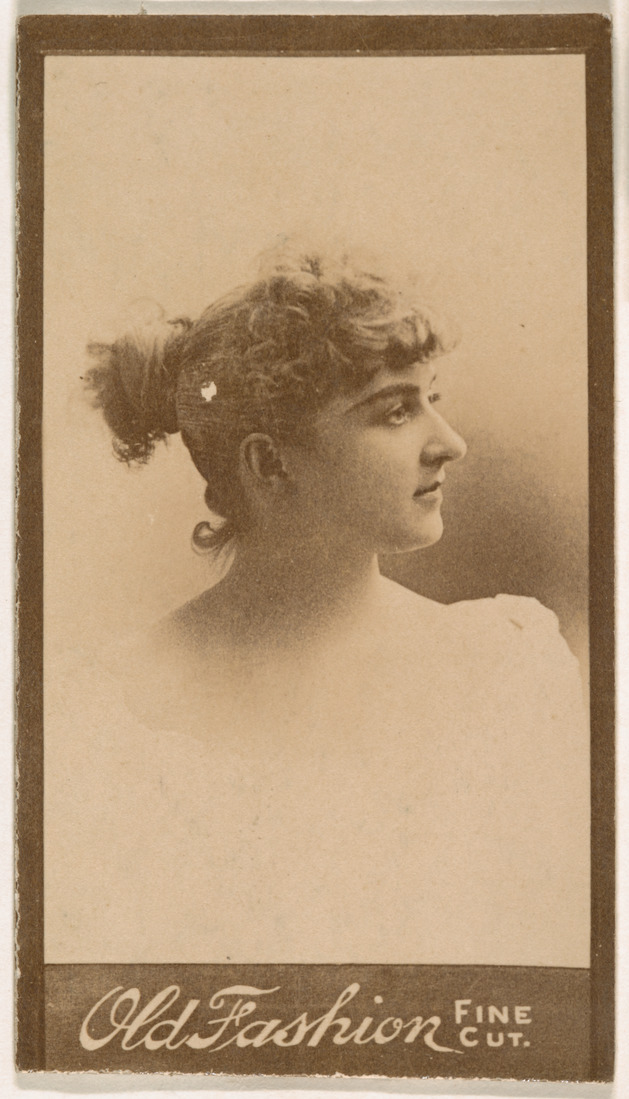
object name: photograph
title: Portrait of actress in profile, from the Actresses series (N664) promoting Old Fashion Fine Cut Tobacco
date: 1888-1890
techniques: albumen silver print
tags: portraits,profiles,women,actresses